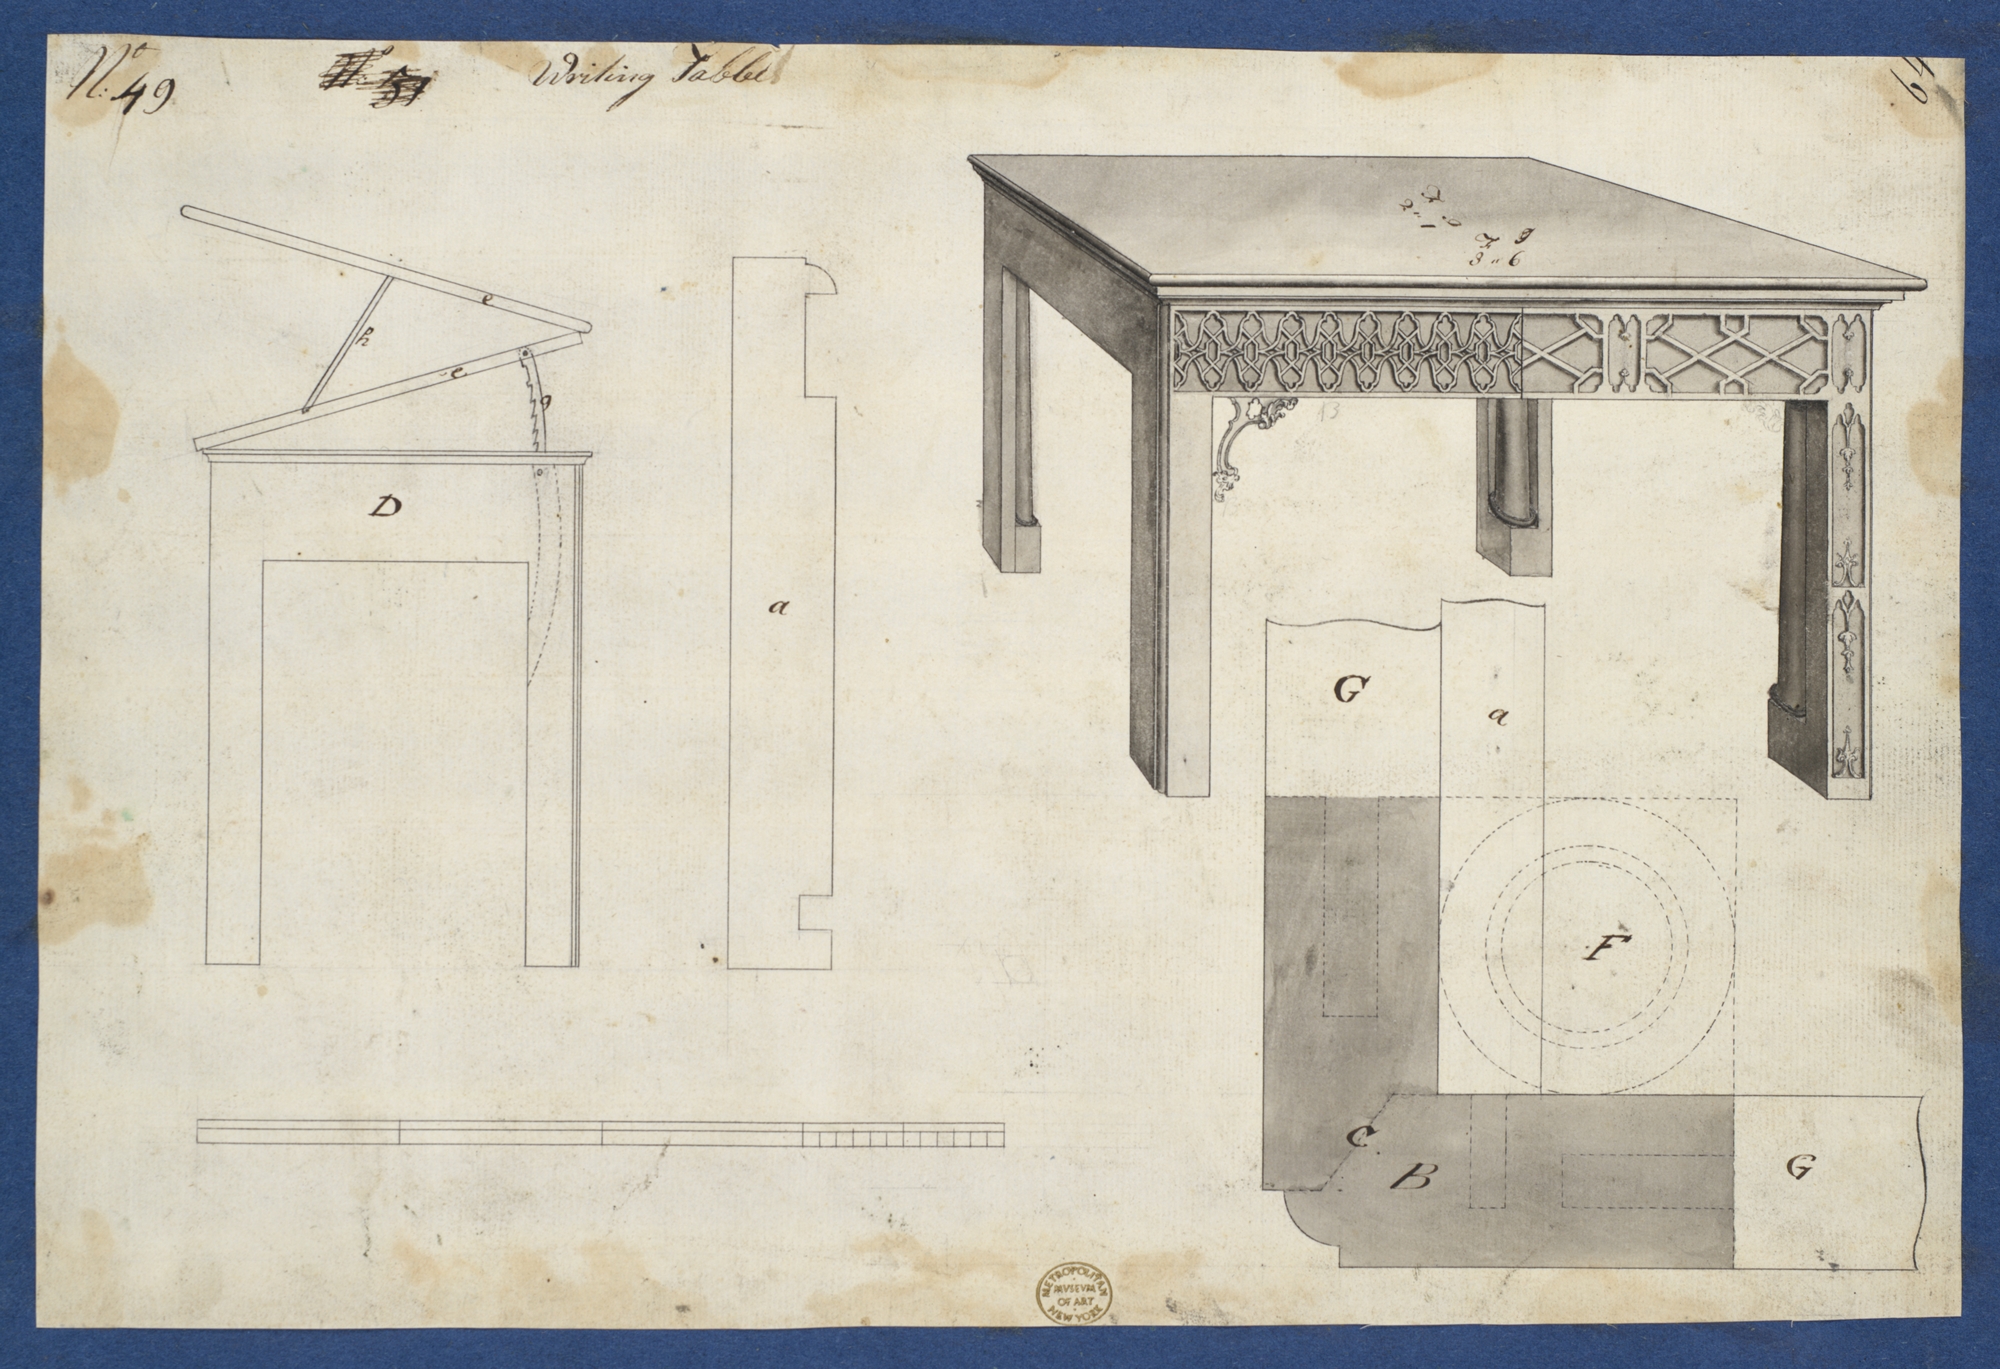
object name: drawing ornament architecture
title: Writing Table, from Chippendale Drawings, Vol. II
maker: thomas chippendale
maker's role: artist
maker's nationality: british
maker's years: 1718-1779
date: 1753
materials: ink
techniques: wash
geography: london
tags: tables